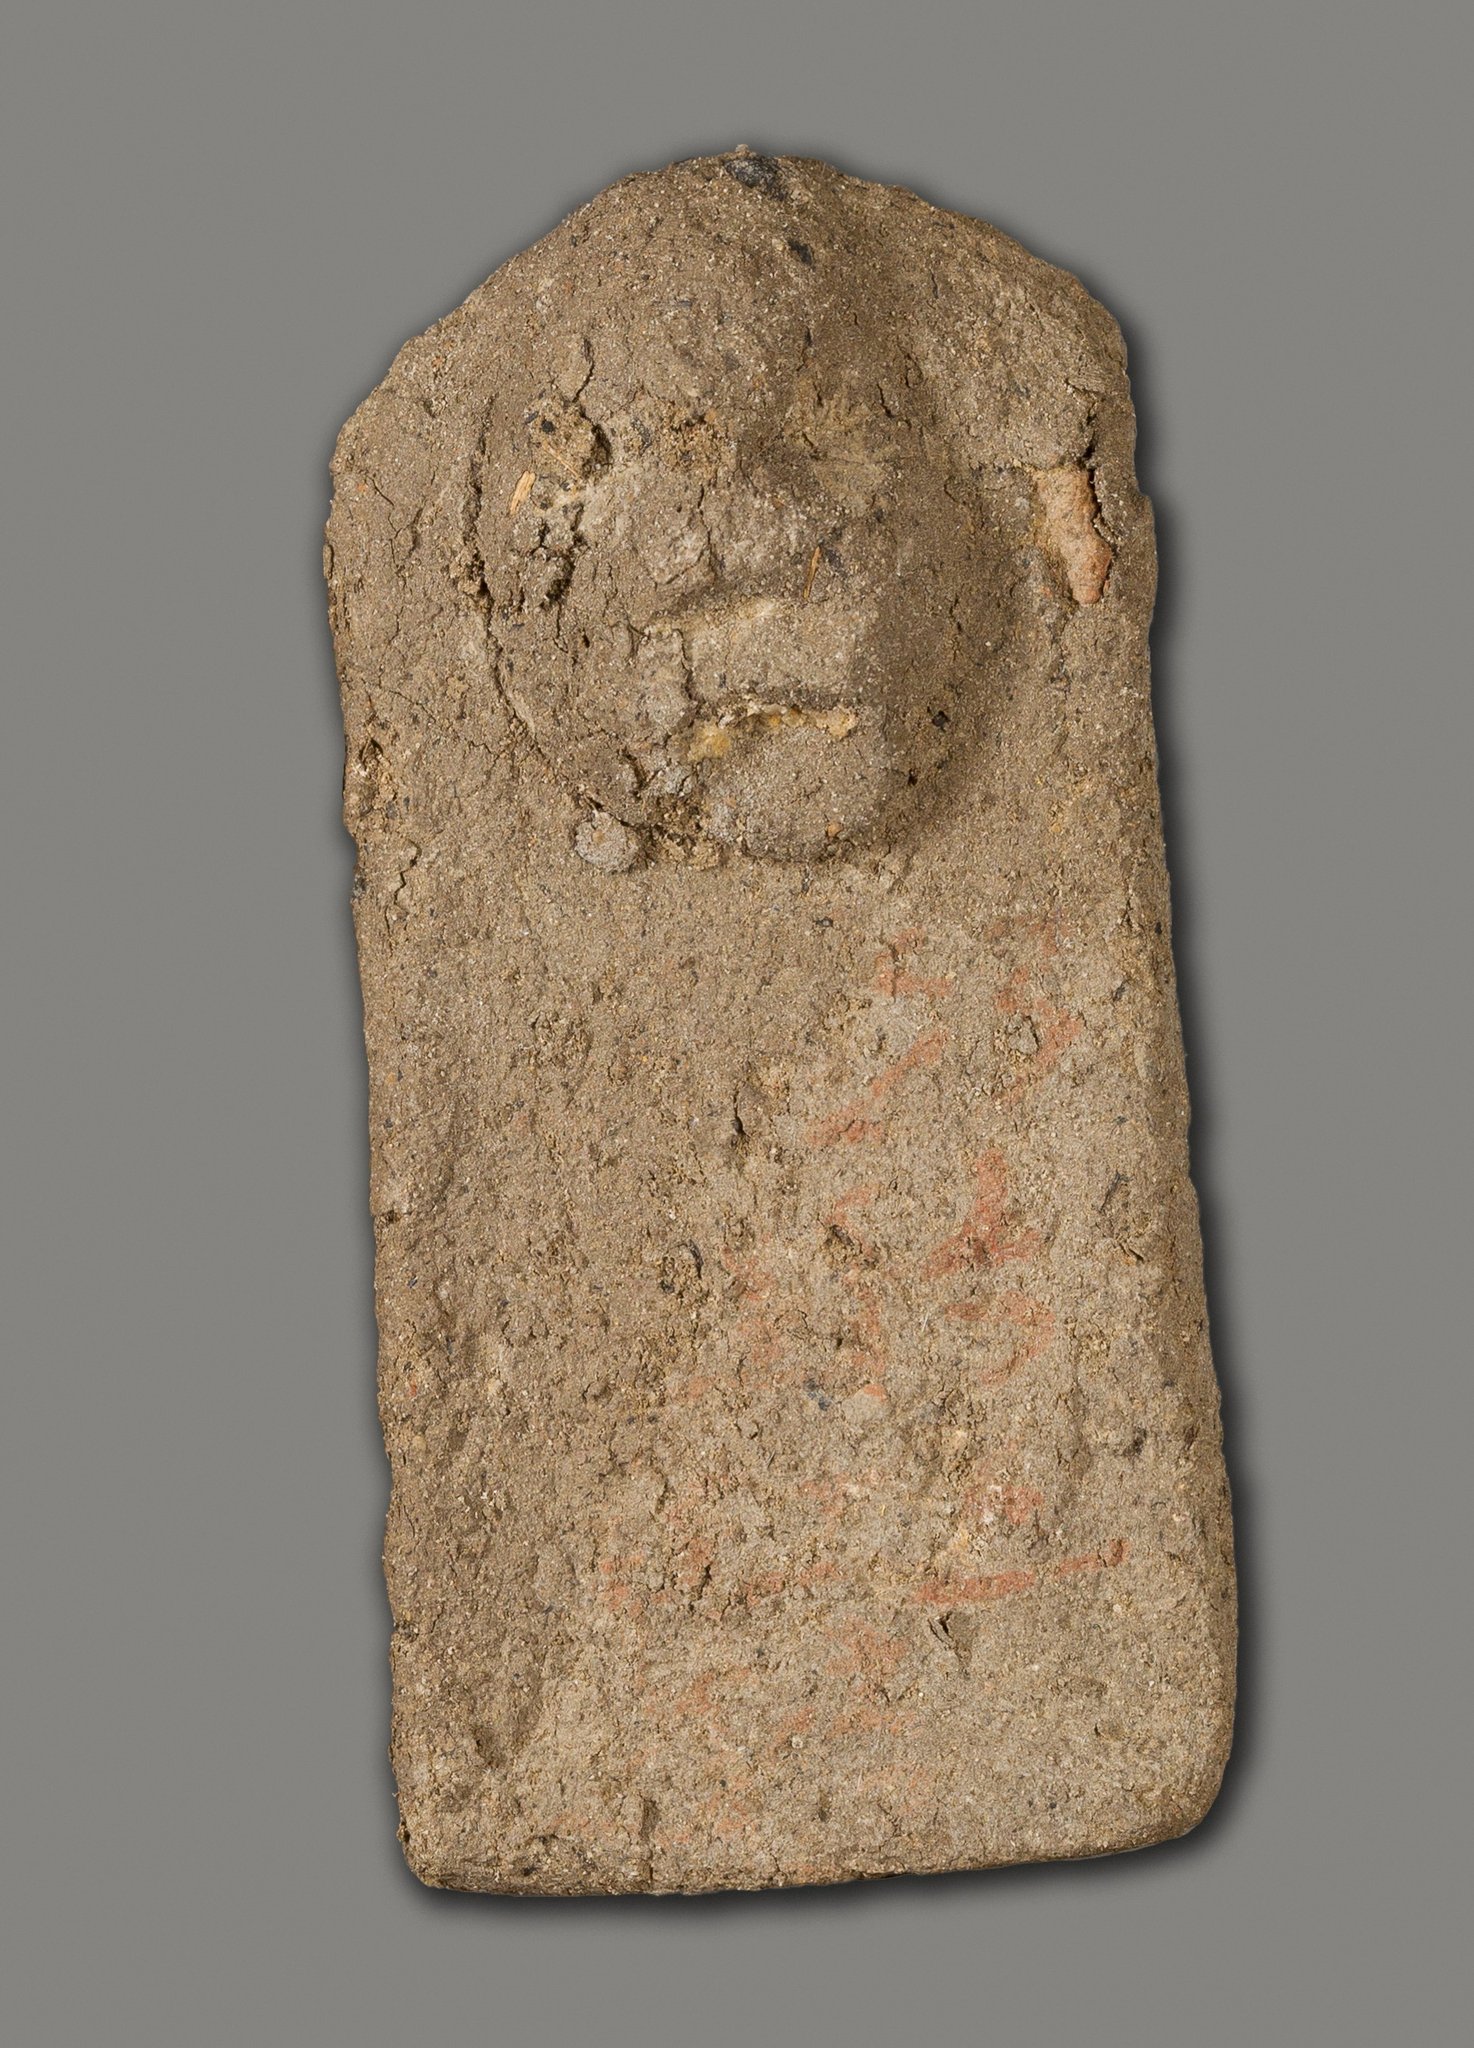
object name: figure, magical, execration, tablet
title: Magical Figure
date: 1802-1550 BCE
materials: clay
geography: egypt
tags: faces